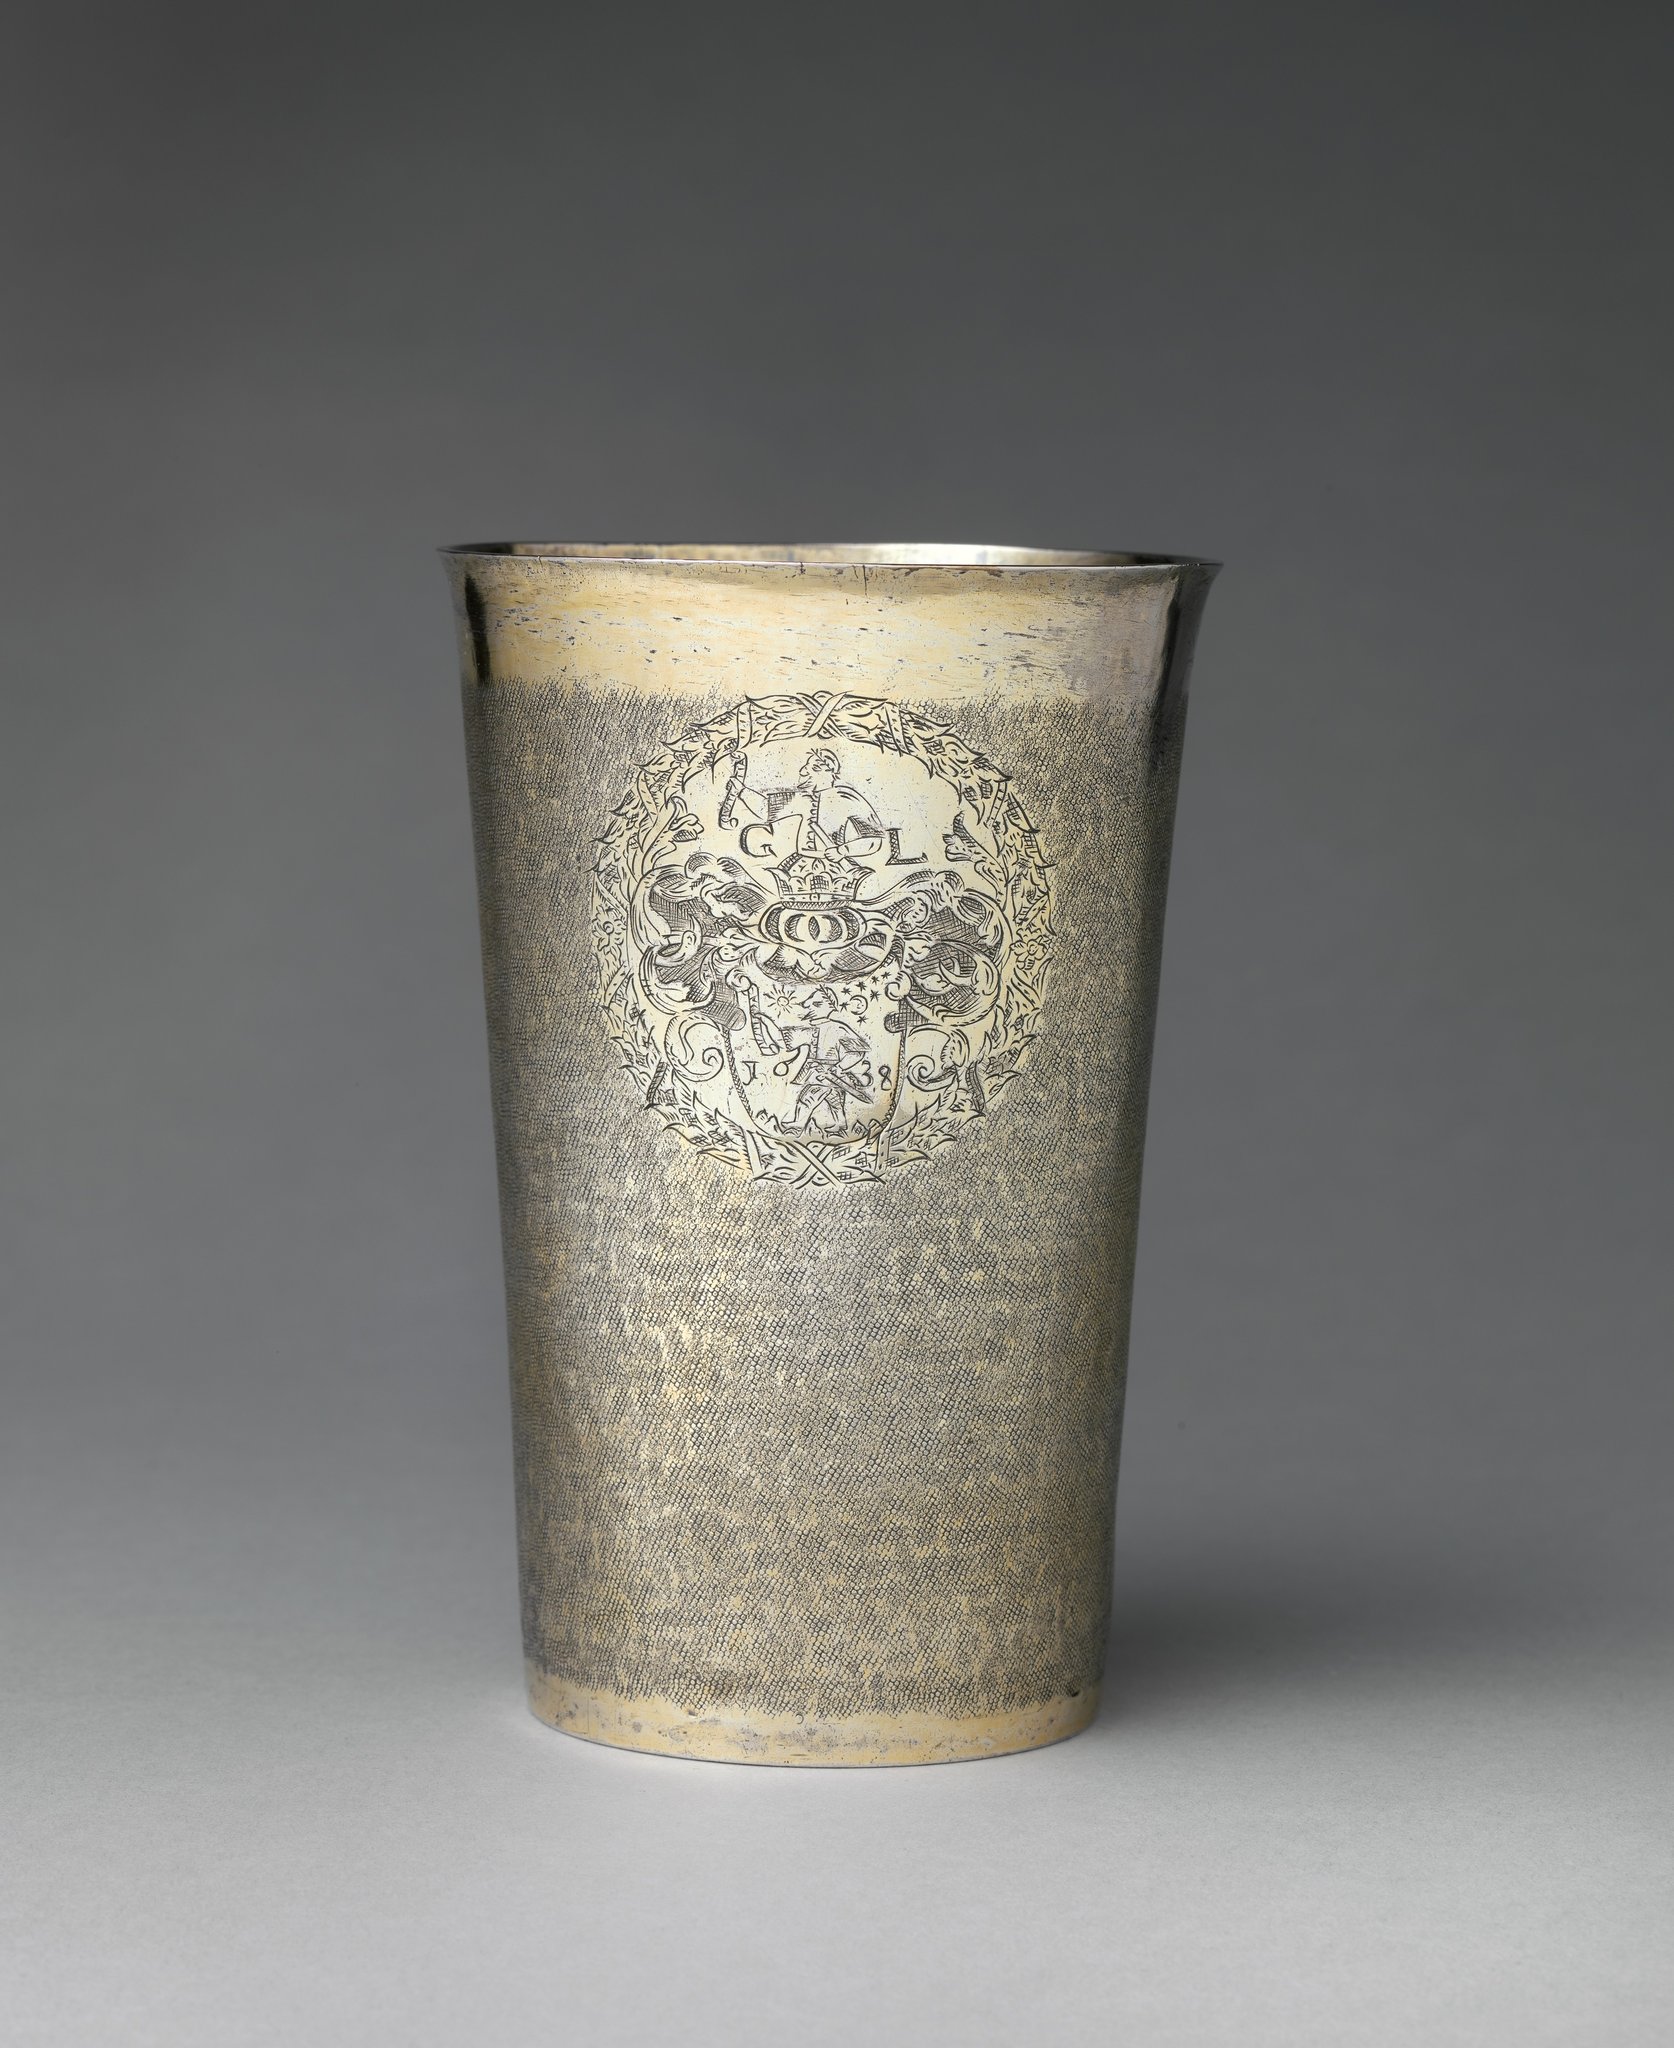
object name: beaker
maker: michael gunterdt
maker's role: maker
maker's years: 1636-1659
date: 1638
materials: gilt silver